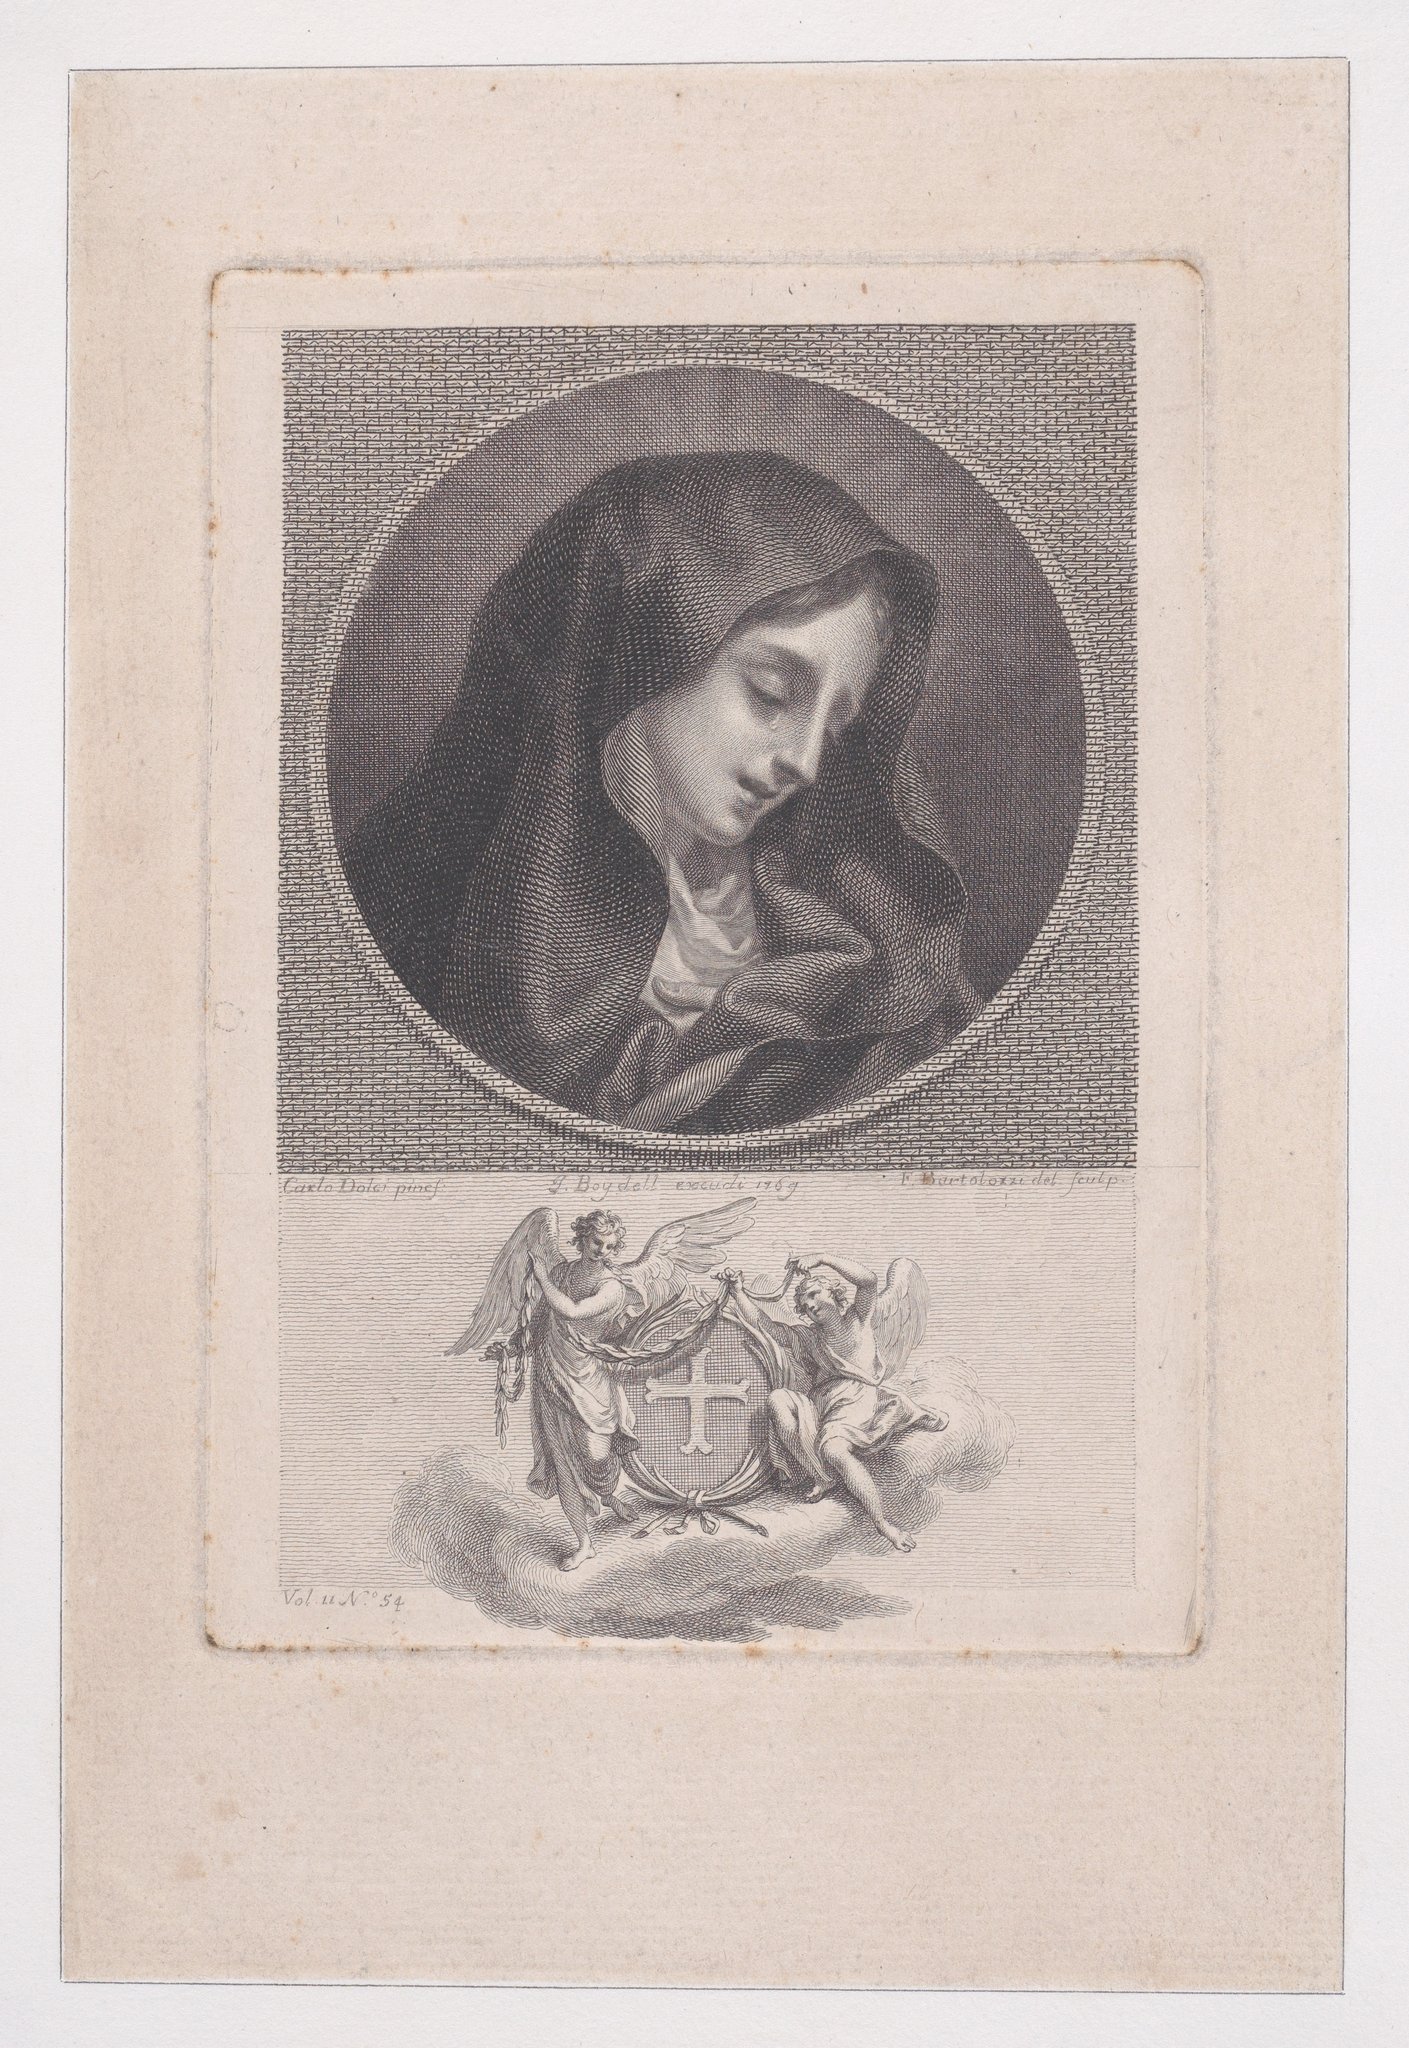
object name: print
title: The Madonna Weeping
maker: francesco bartolozzi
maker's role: artist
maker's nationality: italian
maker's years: 1728-1815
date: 1769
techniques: engraving, etching